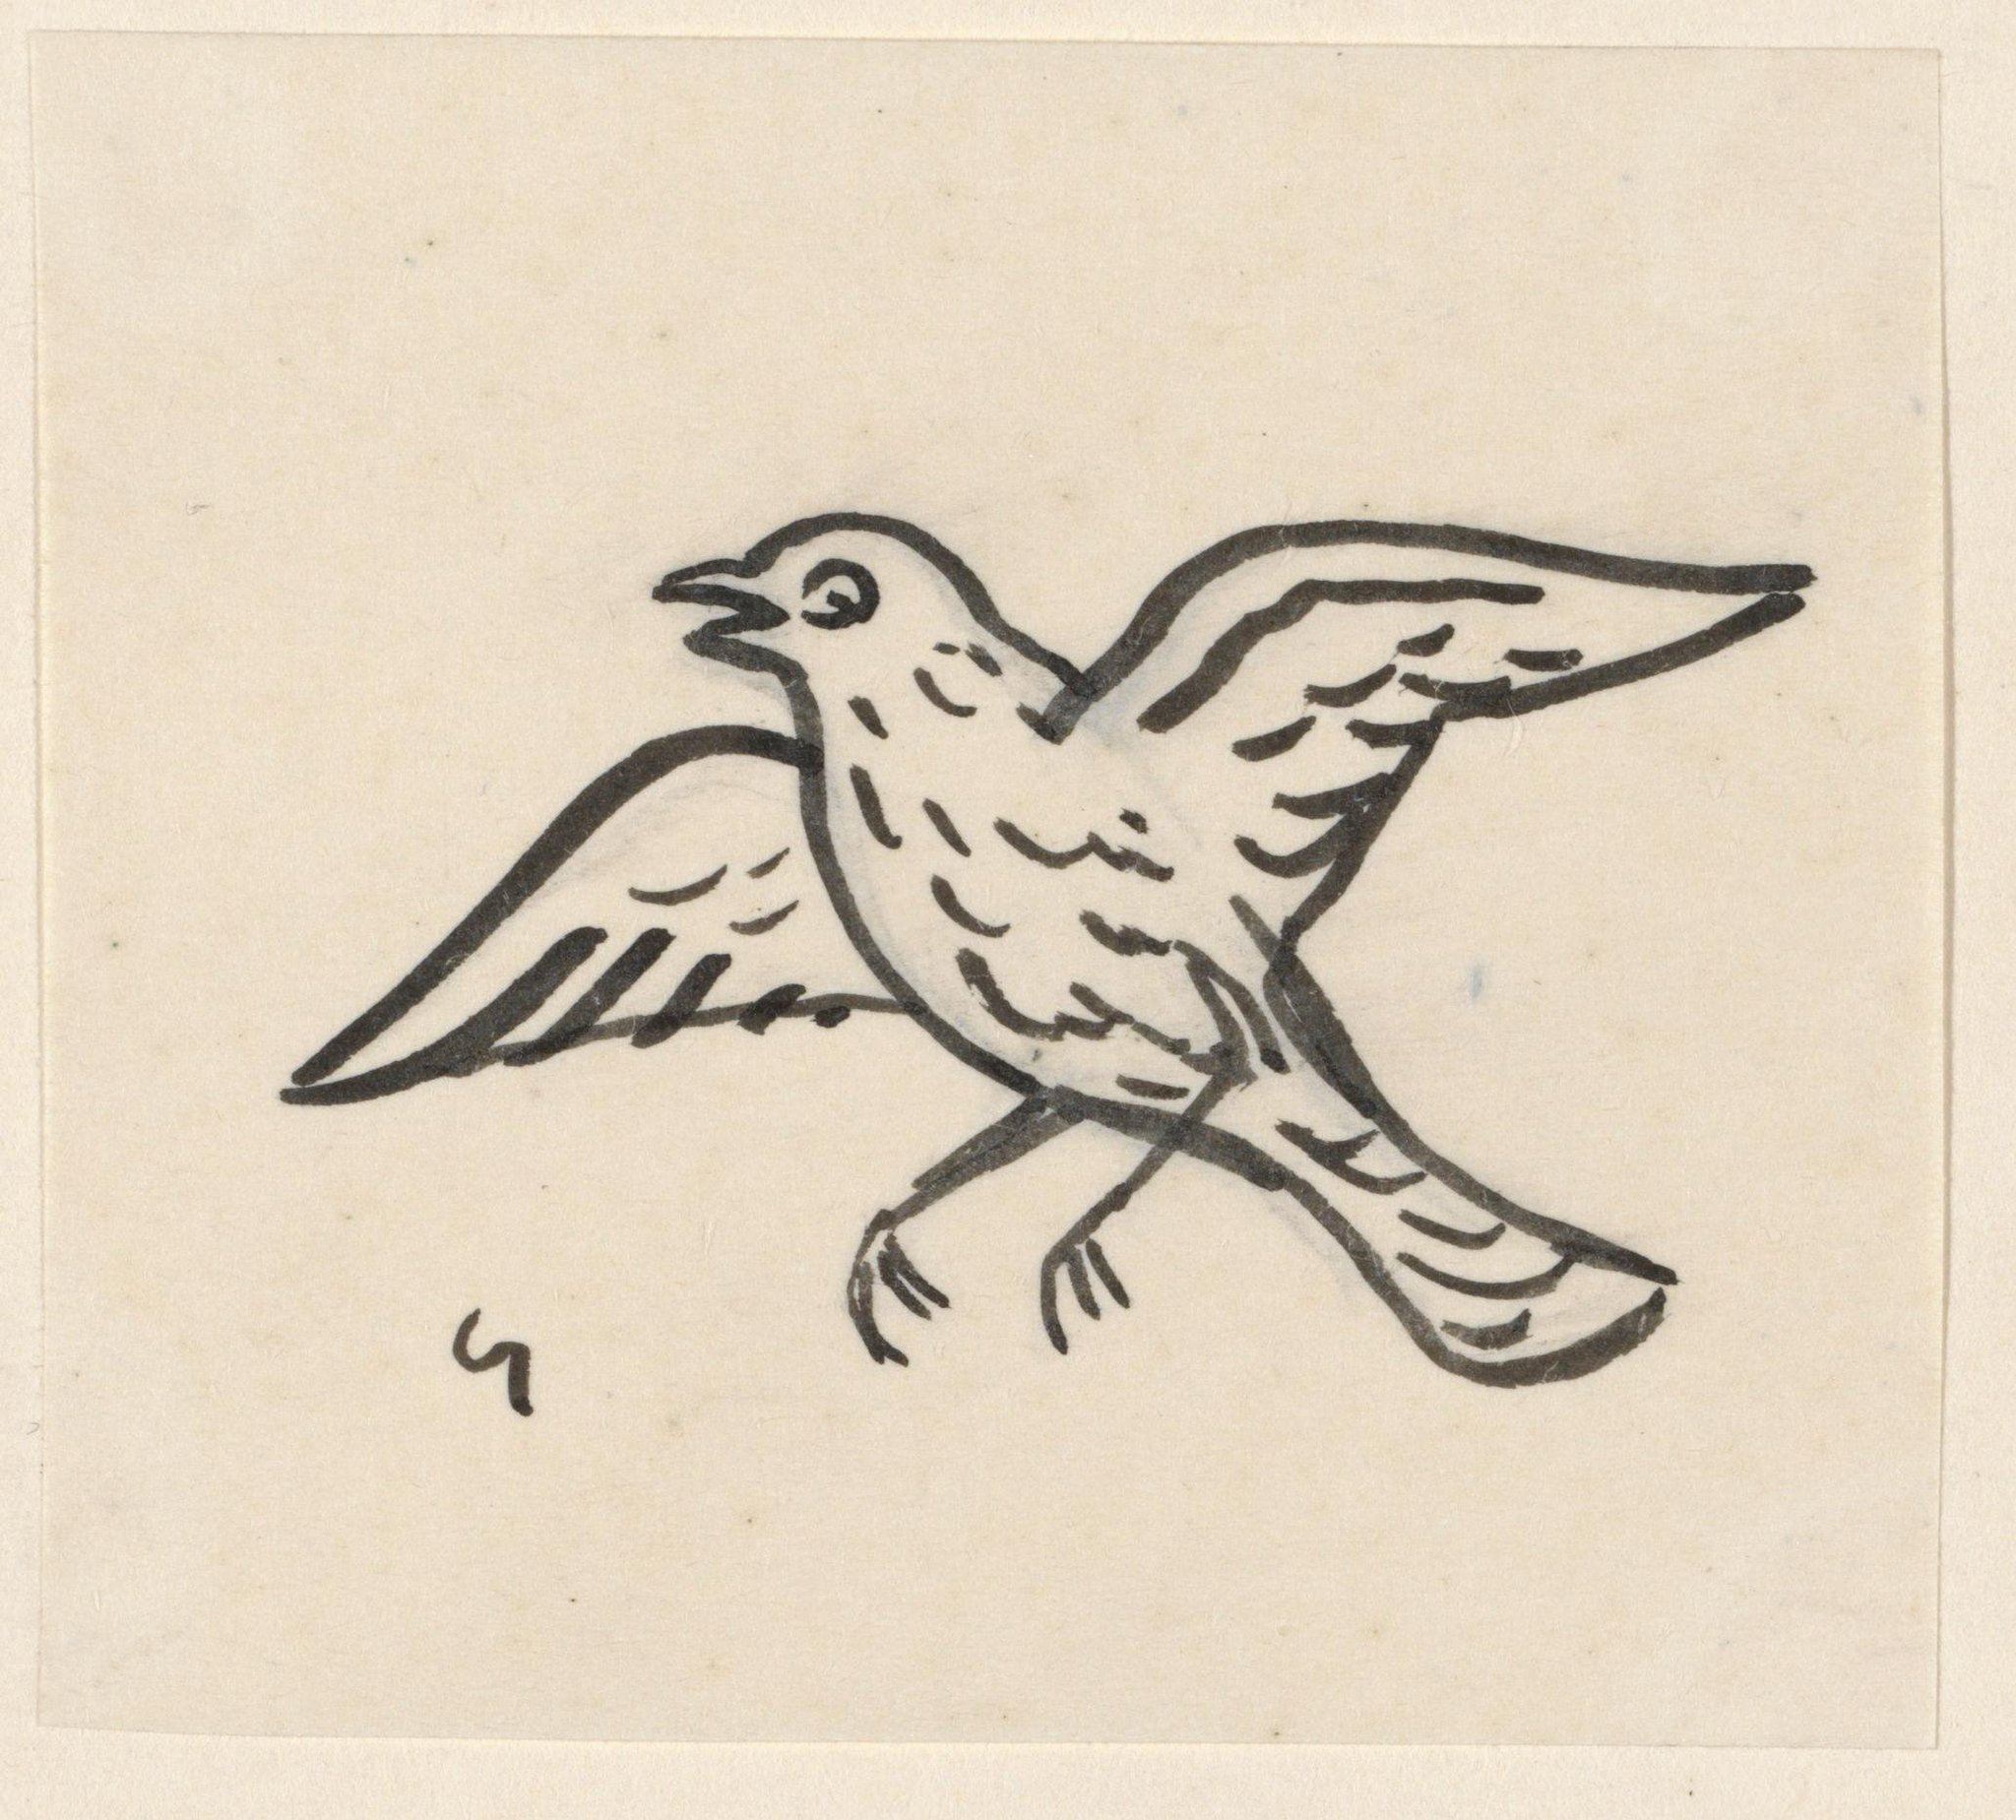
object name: design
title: Vliegende vogel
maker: leo gestel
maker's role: draughtsman, print maker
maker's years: 1881-1941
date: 1891-1941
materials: ink, paper, pencil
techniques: brush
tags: birds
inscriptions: collector's mark: Lugt 2228